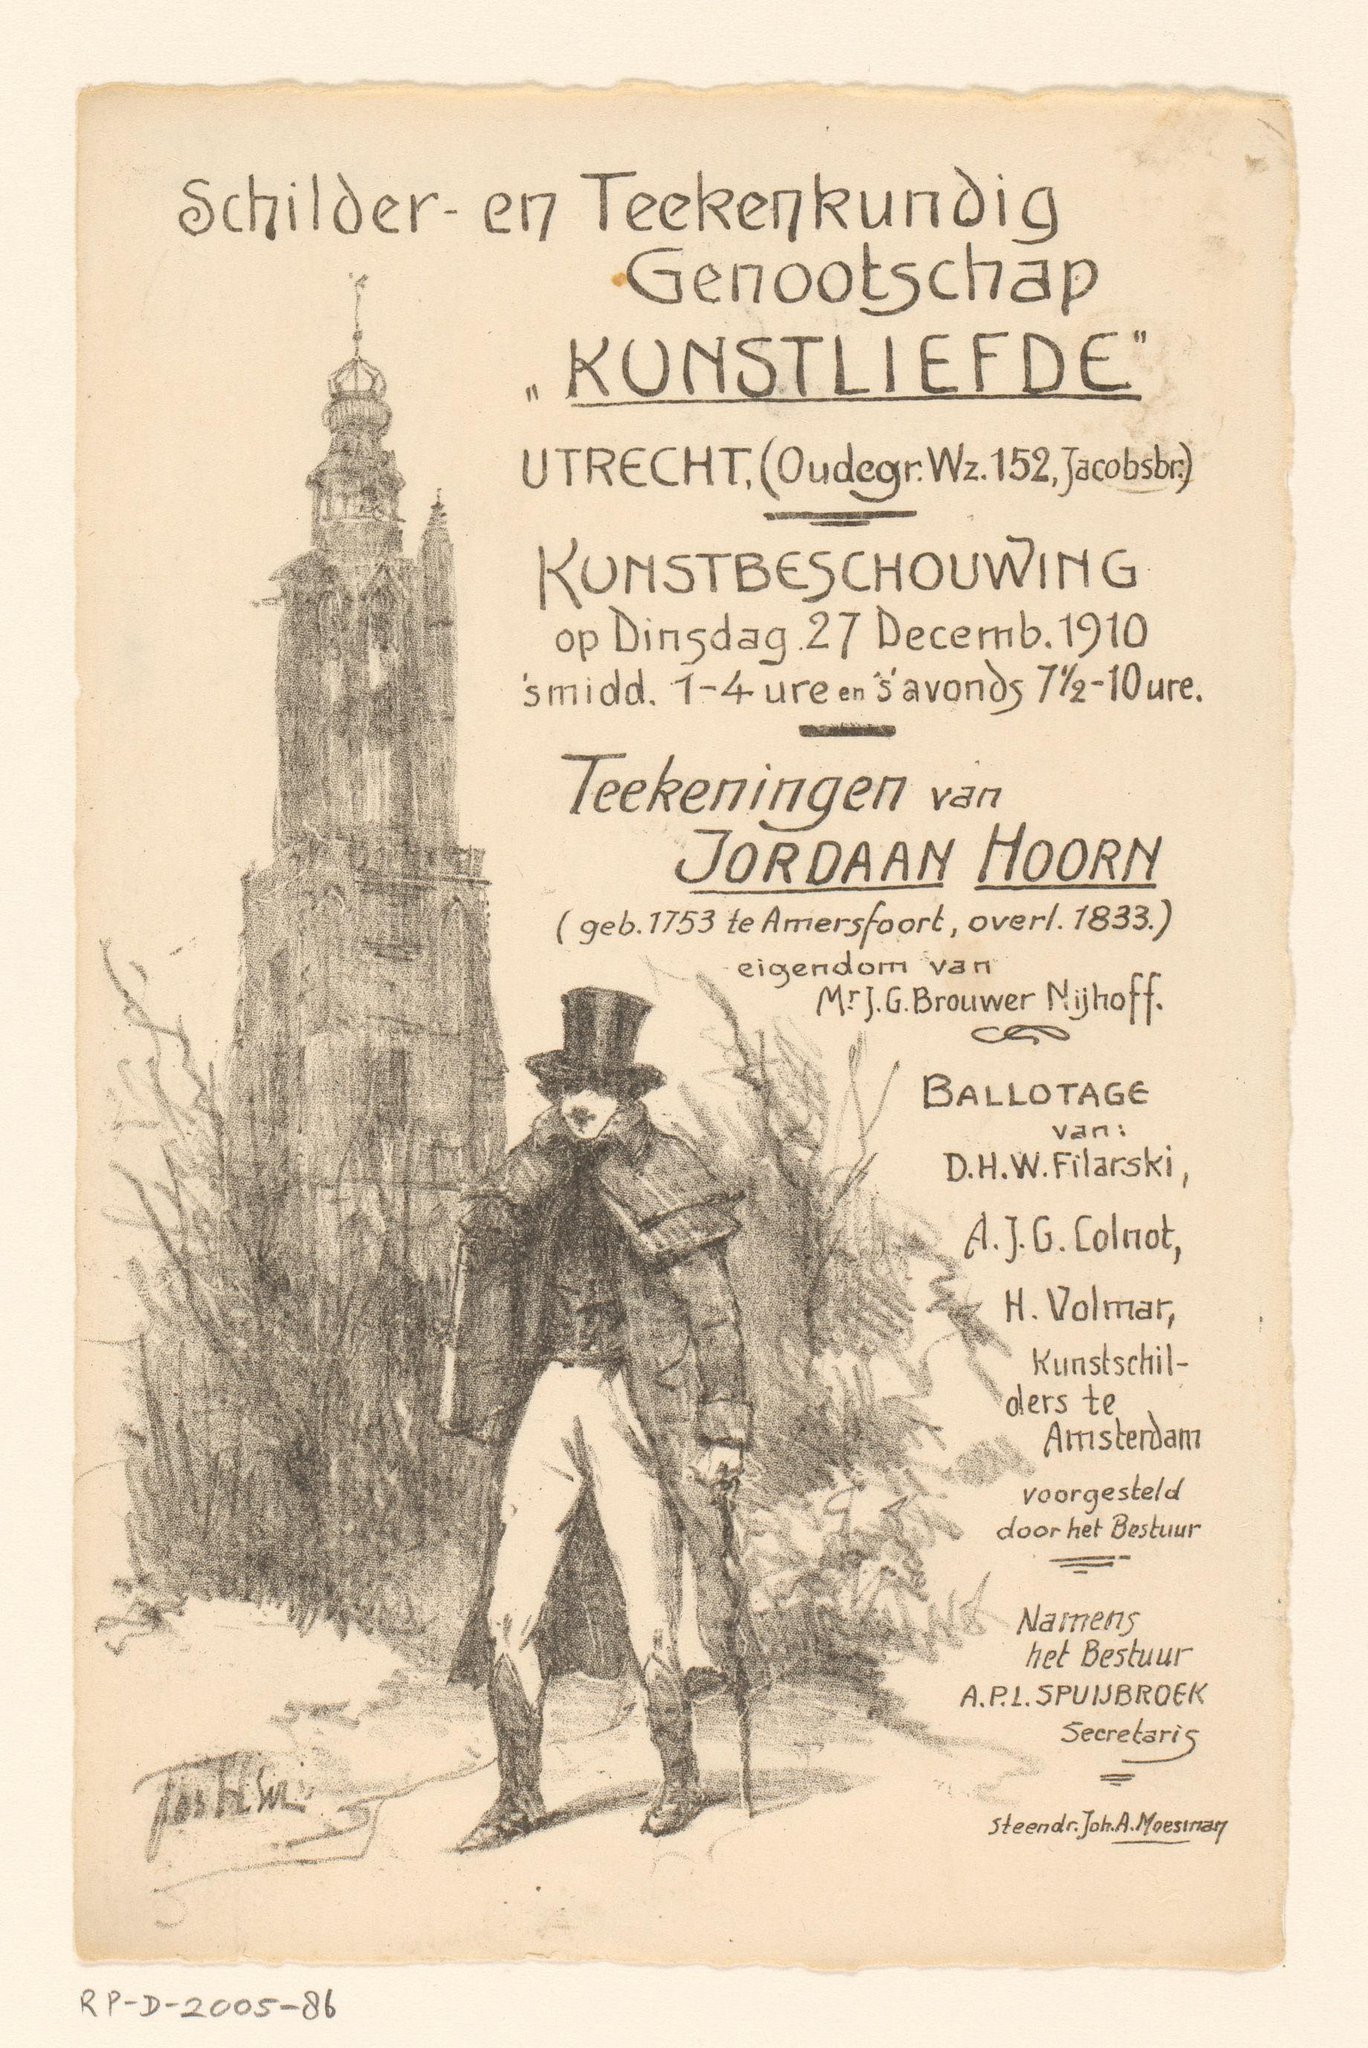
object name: print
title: Uitnodiging van Schilder- en Teekenkundig Genootschap "Kunstliefde" voor een kunstbeschouwing, 27 december 1910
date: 1910-1912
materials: paper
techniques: lithograph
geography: utrecht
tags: draughtsman, jordanus hoorn, criticizing and discussing art, art criticism, circle, club of artists, collecting and exhibiting products of the fine arts, church (exterior)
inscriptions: collector's mark: Lugt 2228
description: Man staande voor de Onze Lieve Vrouwetoren te Amersfoort. Uitnodiging van Schilder- en Teekenkundig Genootschap "Kunstliefde" voor een kunstbeschouwing op 27 december 1910 van tekeningen van Jordanus Hoorn in de collectie van Mr. J.G. Brouwer Nijhoff.